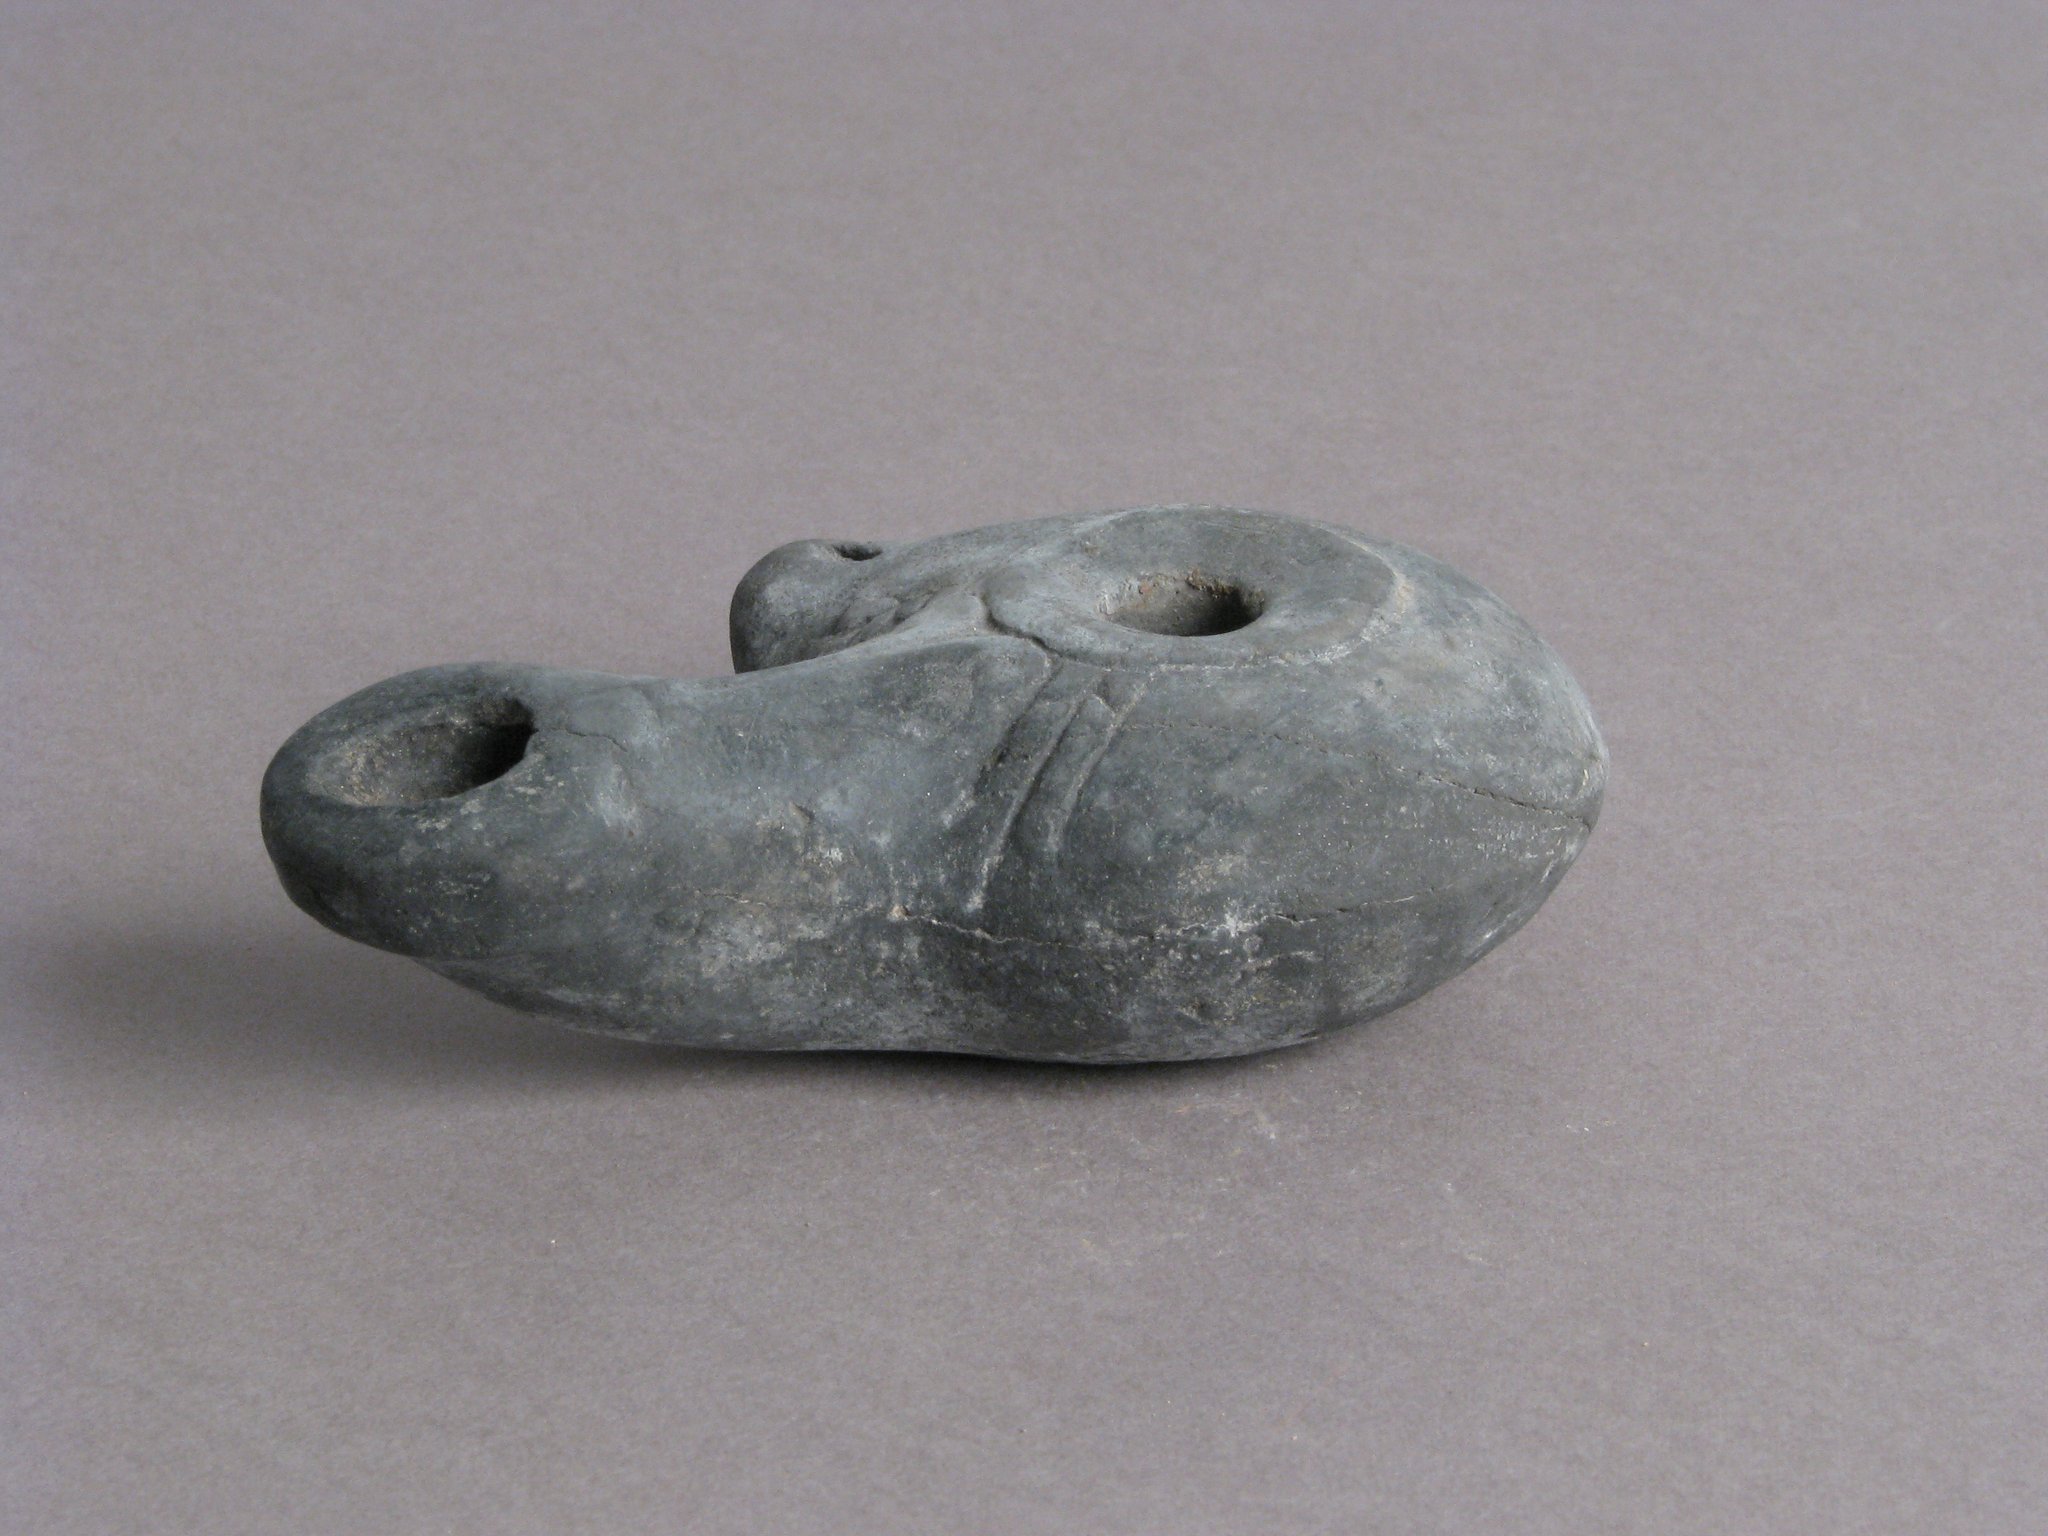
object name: lamp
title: Oil Lamp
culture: coptic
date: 301-700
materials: earthenware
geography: egypt